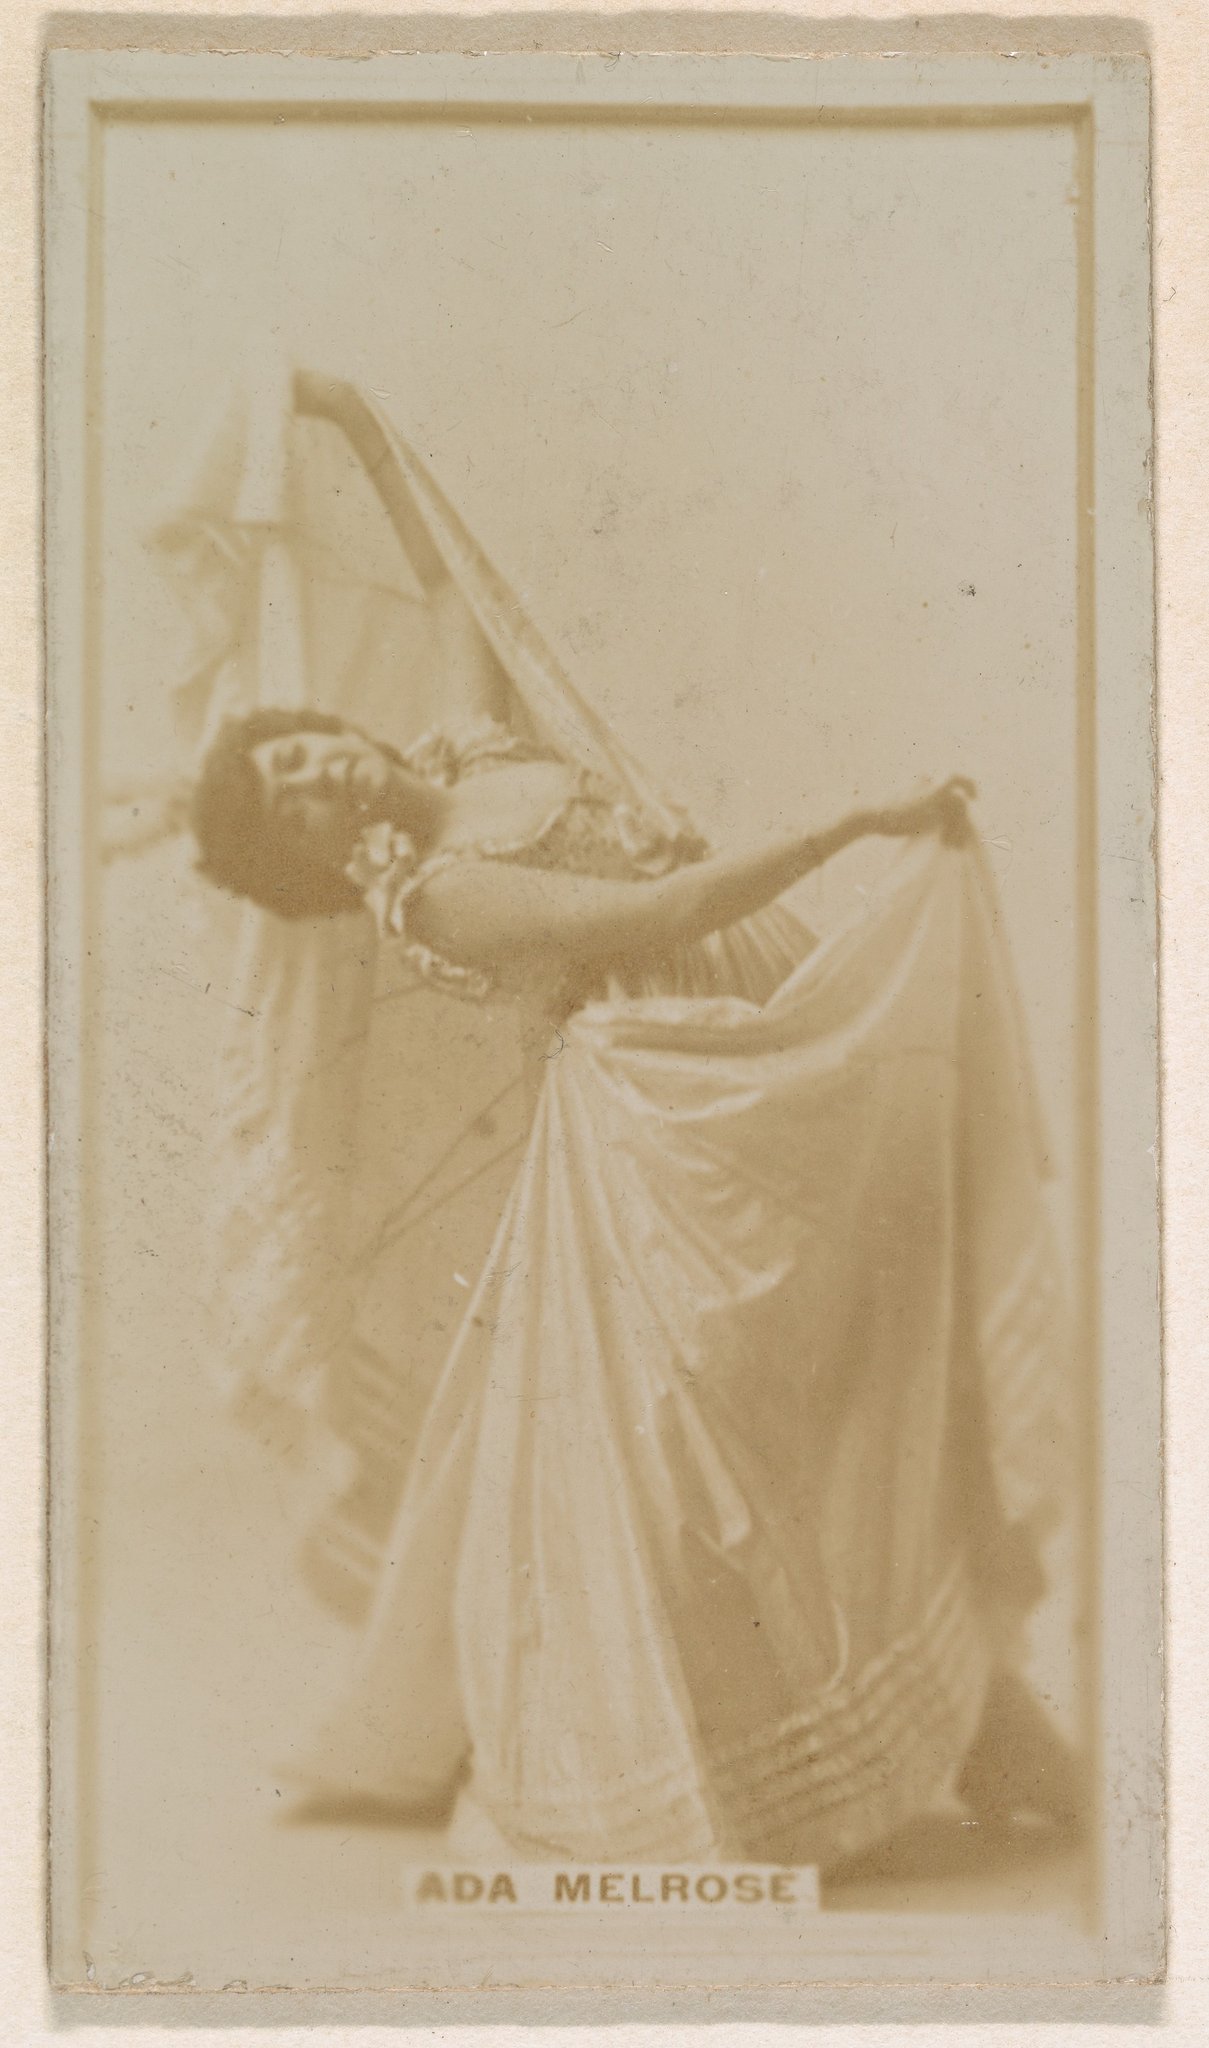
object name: photograph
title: Ada Melrose, from the Actresses series (N245) issued by Kinney Brothers to promote Sweet Caporal Cigarettes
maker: kinney brothers tobacco company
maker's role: publisher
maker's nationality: american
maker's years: 1869-2011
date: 1890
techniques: albumen silver print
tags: portraits,women,actresses